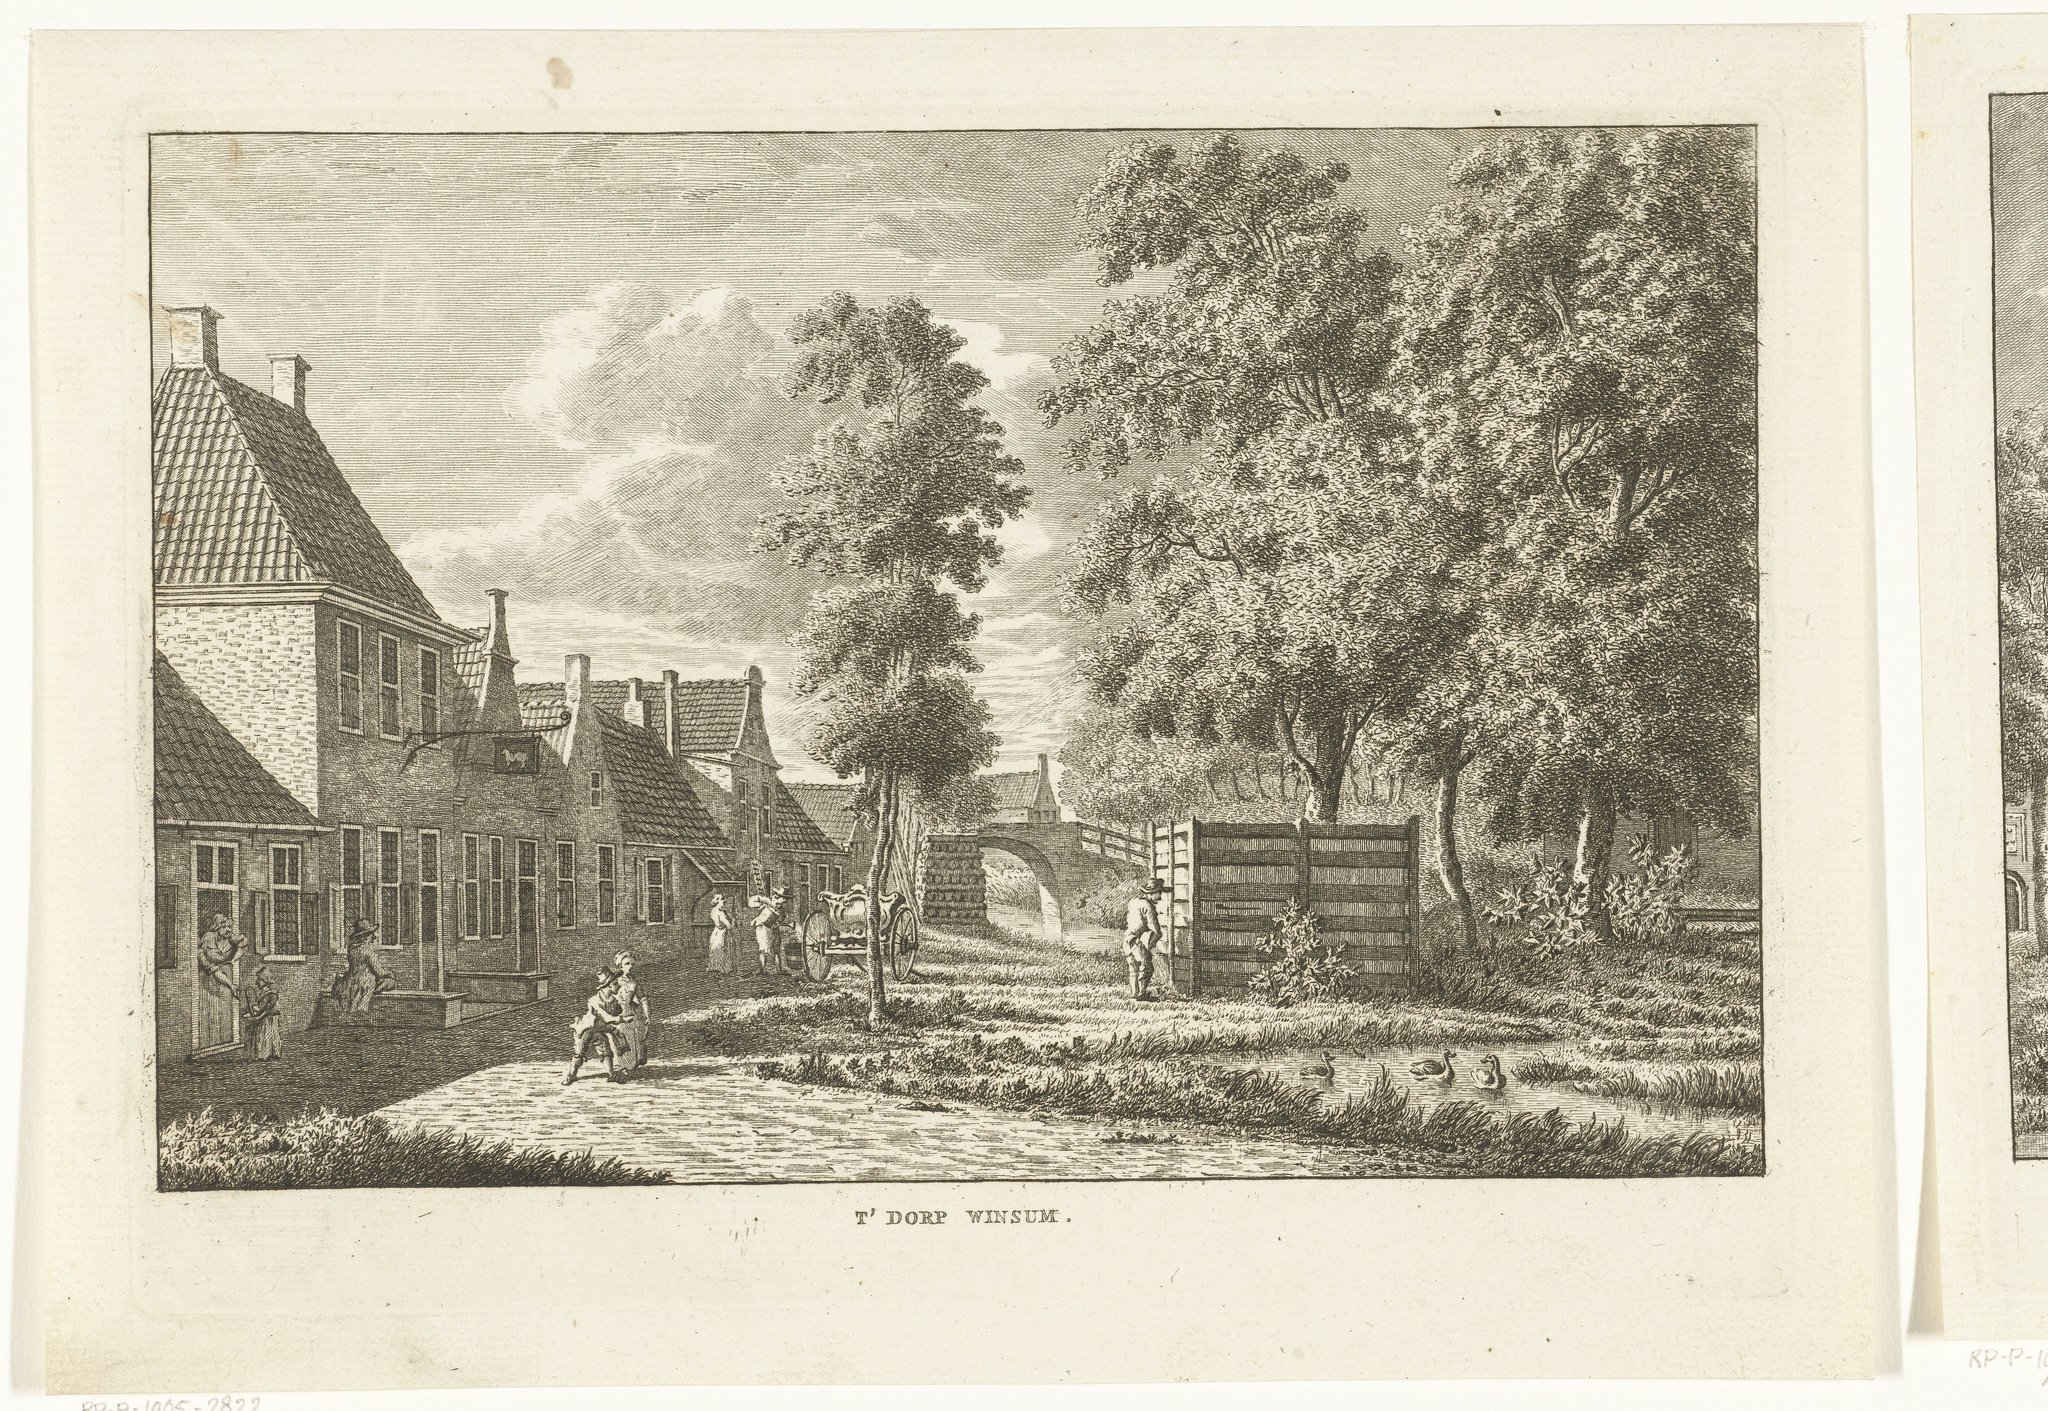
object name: print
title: T' Dorp Winsum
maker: carel frederik bendorp (i)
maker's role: print maker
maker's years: 1736-1814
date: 1786-1792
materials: paper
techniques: etching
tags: village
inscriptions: collector's mark: Lugt 2228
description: Prent uit: Vaderlandsche gezichten, of afbeeldingen van den tegenwoordigen staat der Vereenigde Nederlanden (…). Amsterdam: Hendrik Gartman, Willem Vermandel en Jan Willem Smit, 1786-1792. Uitgegeven in afleveringen met ieder een eigen bifolium en inhoudsopgave. Alle prenten in deze publicatie zijn gegraveerd door Carel Frederik Bendorp (I) en, in de meeste gevallen, gebaseerd op tekeningen van Jan Bulthuis.